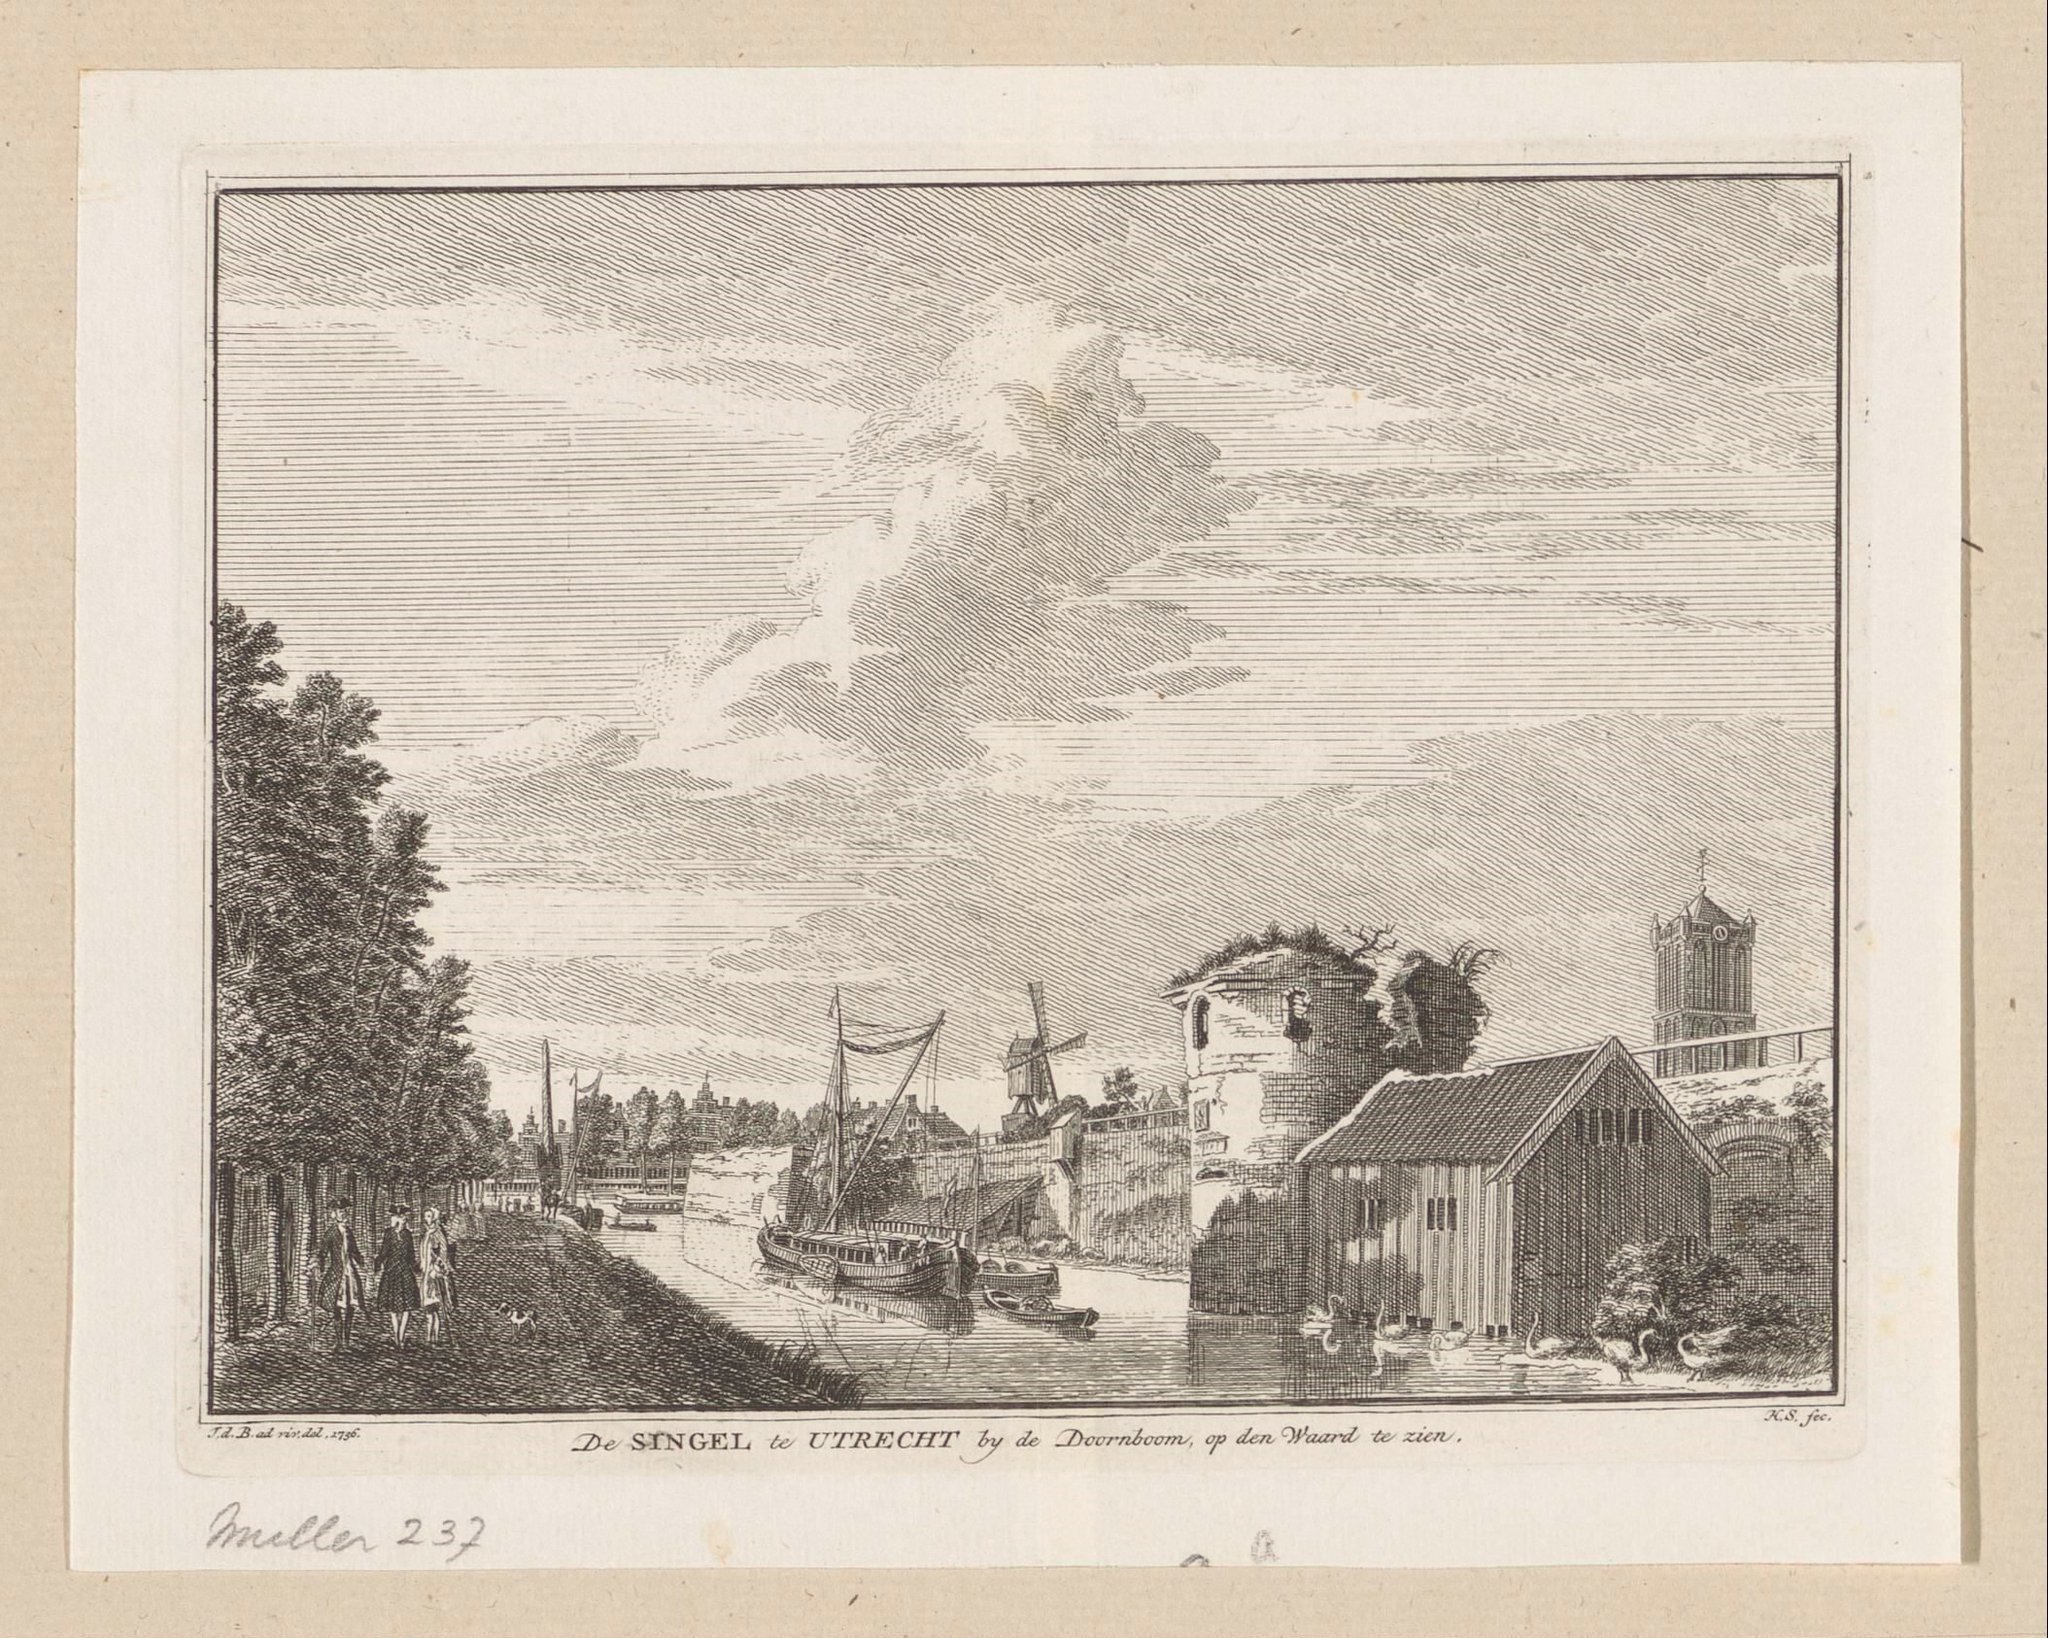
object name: print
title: Gezicht op de stadswal en de toren Het Paard te Utrecht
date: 1773-1792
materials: paper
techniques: engraving, etching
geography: haarlem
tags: towers ~ fortified city, city-walls, windmill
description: Prent ook gebruikt in: Het verheerlykt Nederland of kabinet van hedendaagsche gezigten van steden, dorpen (…) Behelzende honderd gezigten van der Provincie van Utrecht. Amsterdam: weduwe Isaak Tirion, 1773-1774, dl. 7, 8 of 9, niet genummerd, te vinden na ill. 144 en voor ill. 201. Of in: Nederlandsche tafereelen; of eene keurige verzameling van negen honderd fraaije gezigten van steden, dorpen, sloten, oudheden (….). 9 delen. Amsterdam: Jan de Groot, 1792, dl. 7, 8 of 9, niet genummerd, te vinden na ill. 144 en voor ill. 201. Uit welke druk het huidige exemplaar precies komt is niet na te gaan.